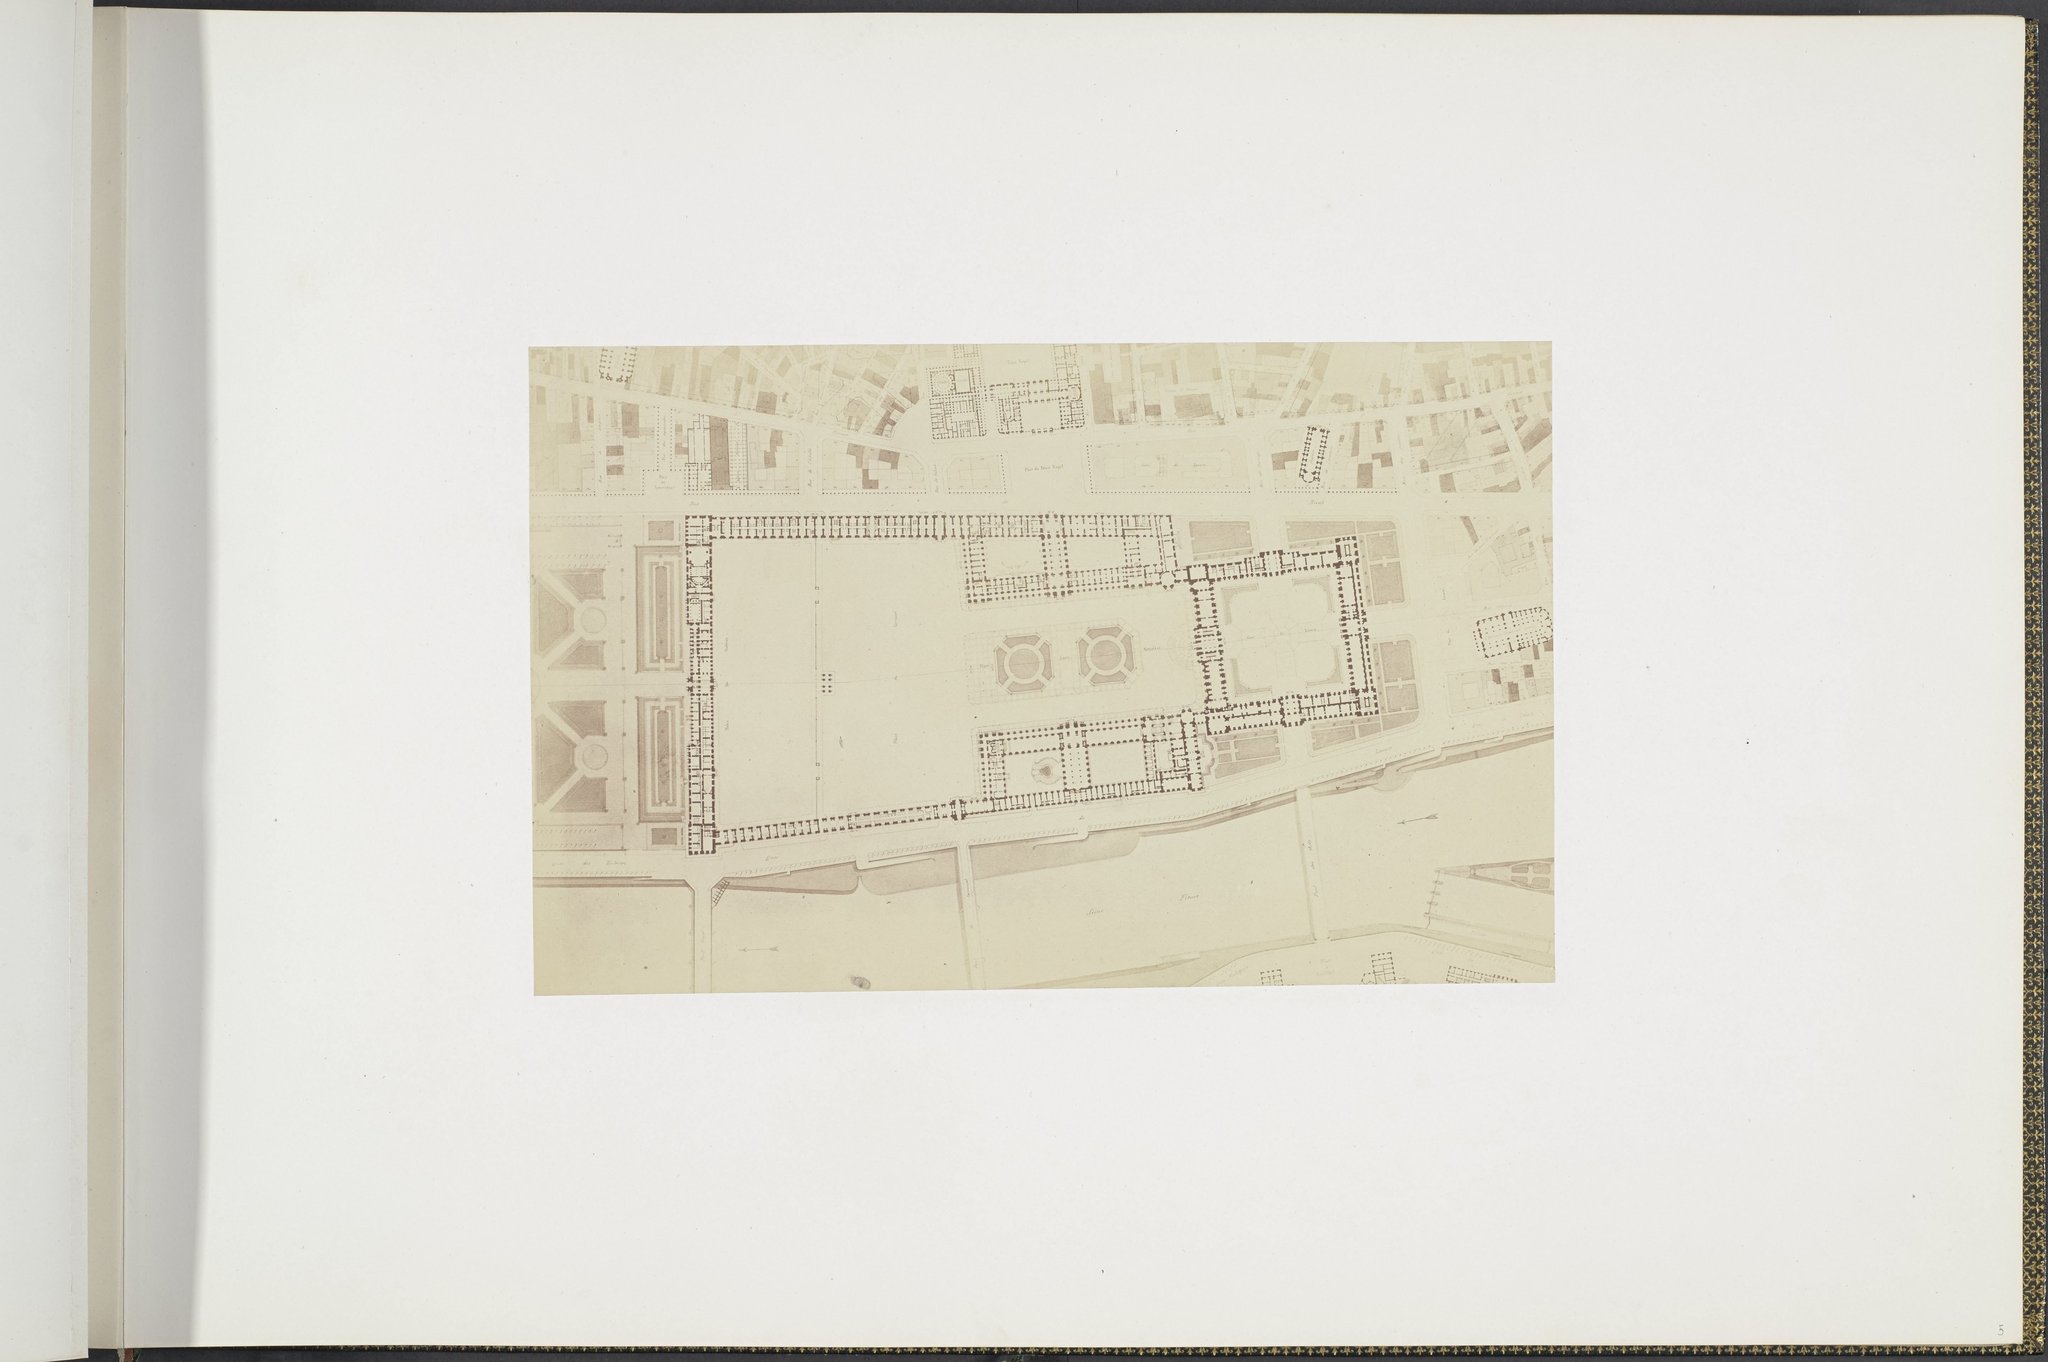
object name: photograph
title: Plattegrond van het Nieuwe Louvre volgens ontwerp van architect L. Visconti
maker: édouard denis baldus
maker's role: fotograaf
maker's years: 1813-1889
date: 1857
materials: paper, photographic support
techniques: salted paper print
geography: paris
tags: permanent exhibition, museum, paris, tuileries palace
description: Onderdeel van Réunion des Tuileries au Louvre 1852-1857, album 1.